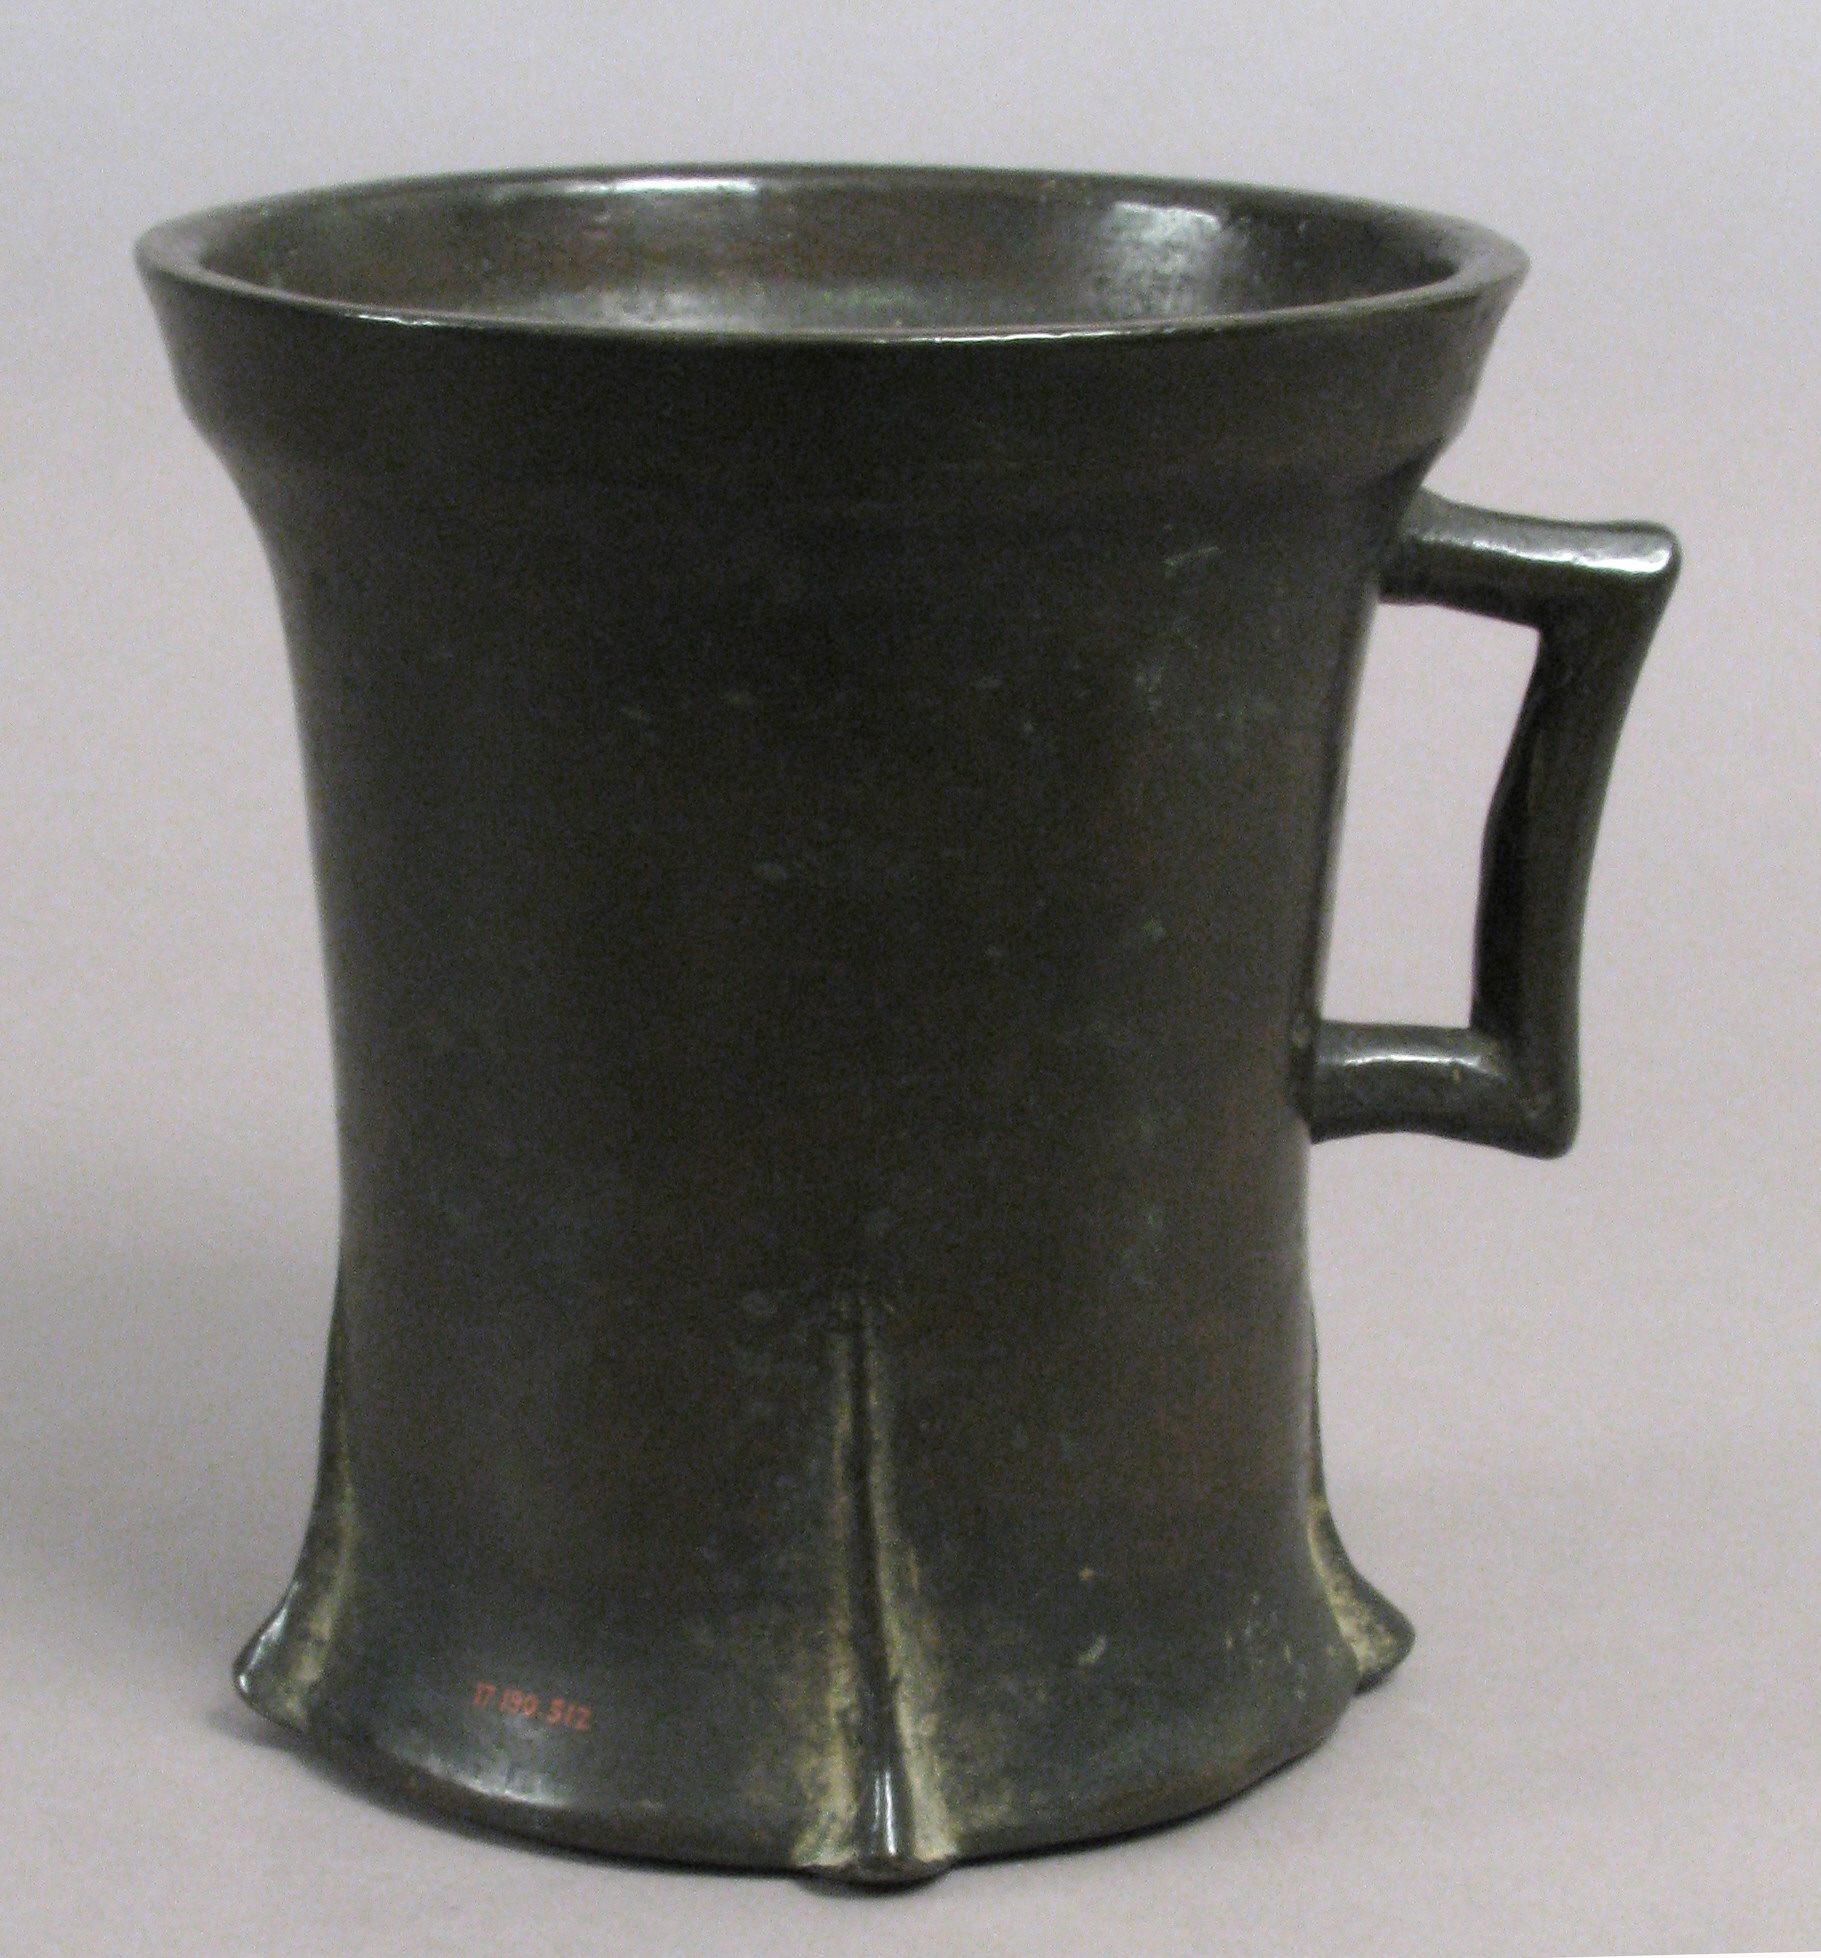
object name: mortar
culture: french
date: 1501-1600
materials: copper alloy